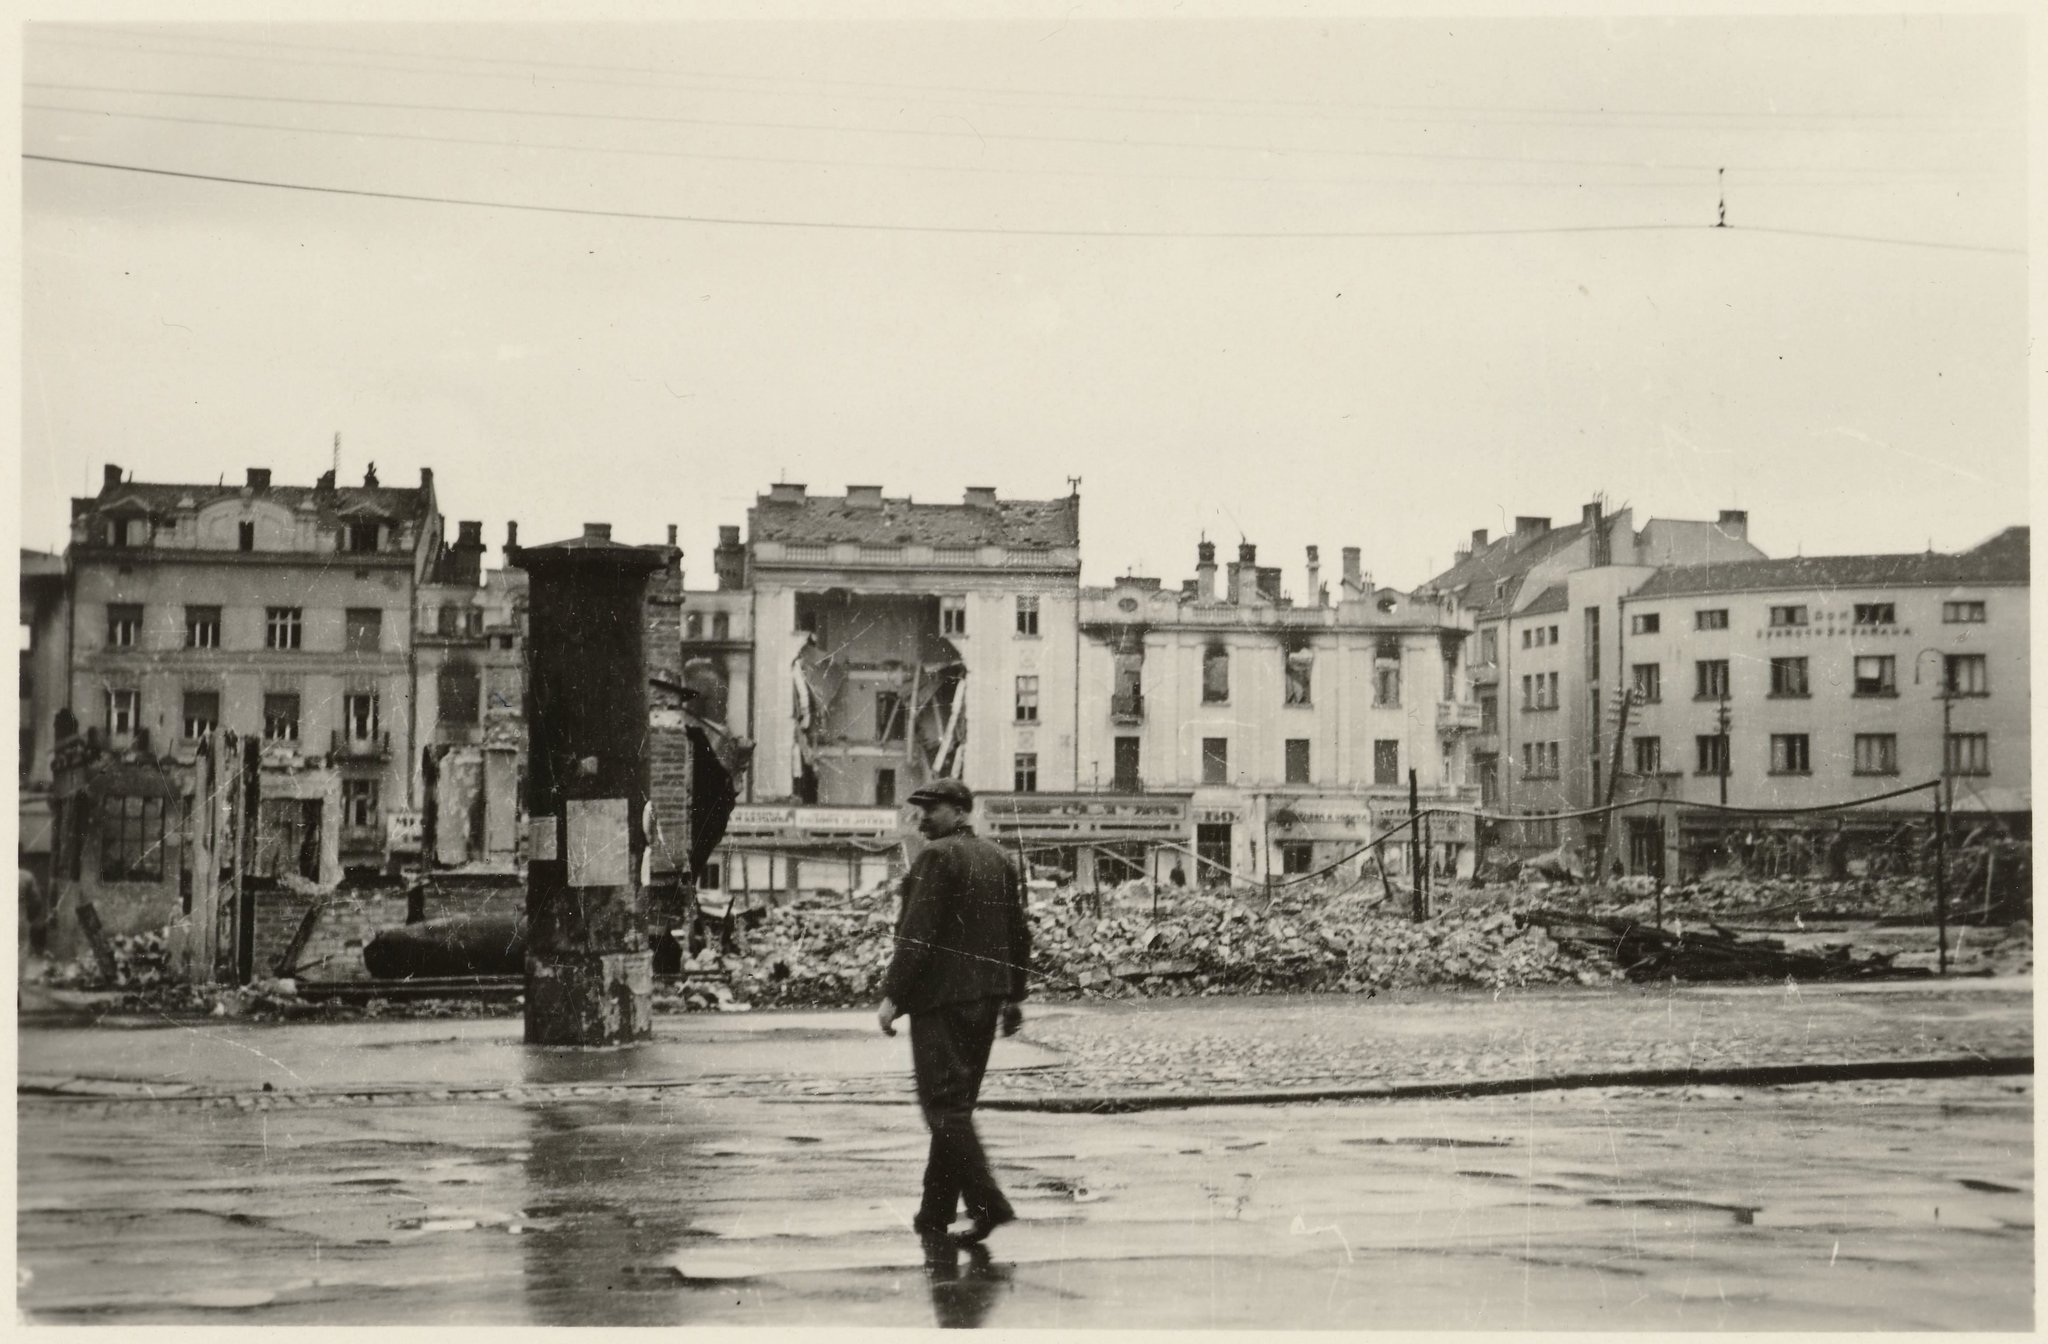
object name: photograph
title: Oorlogsverwoestingen in Belgrado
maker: Anonymous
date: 1940-1945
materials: photographic support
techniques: gelatin silver print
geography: belgrade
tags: germany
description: Oorlogsverwoestingen in Belgrado. Foto behorend bij album 'Kriegserinnerungen'.